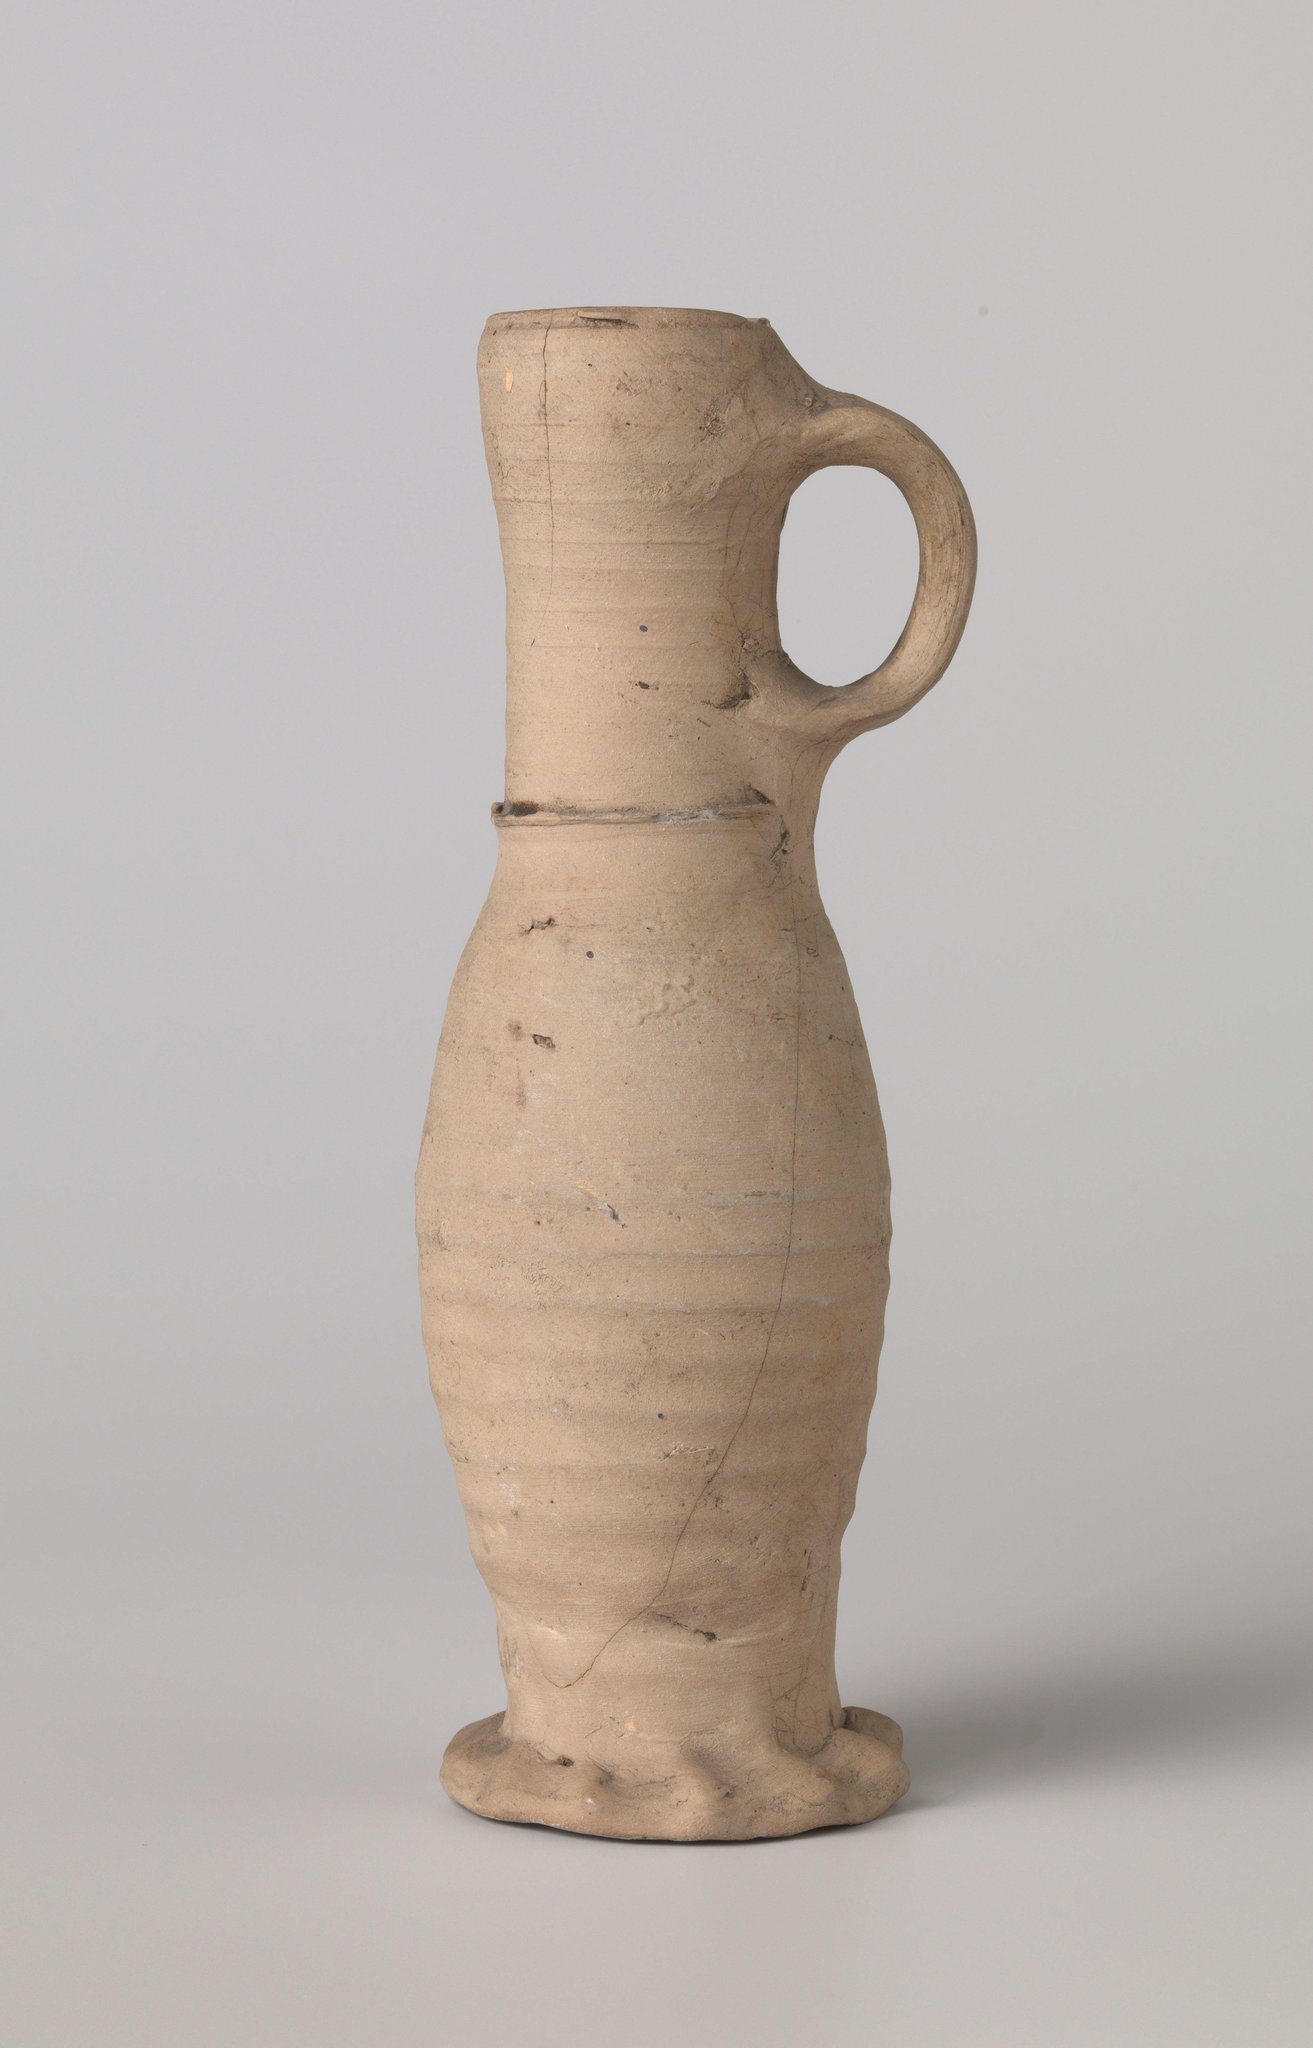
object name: jacobakan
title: Jug or 'Jacobakan'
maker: Anonymous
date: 1450-1549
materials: earthenware, stoneware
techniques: firing, forming, turning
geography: siegburg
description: Geribde, smalle kan (Jacobakan) van steengoed[?] op gegolfde voet met een eivormig lichaam en lange nek. Het C-vormige oor is bevestigd aan de nek. De kan is versierd met draairingen en een profiel op de schouder. Mogelijk een vervalsing. Siegburg.